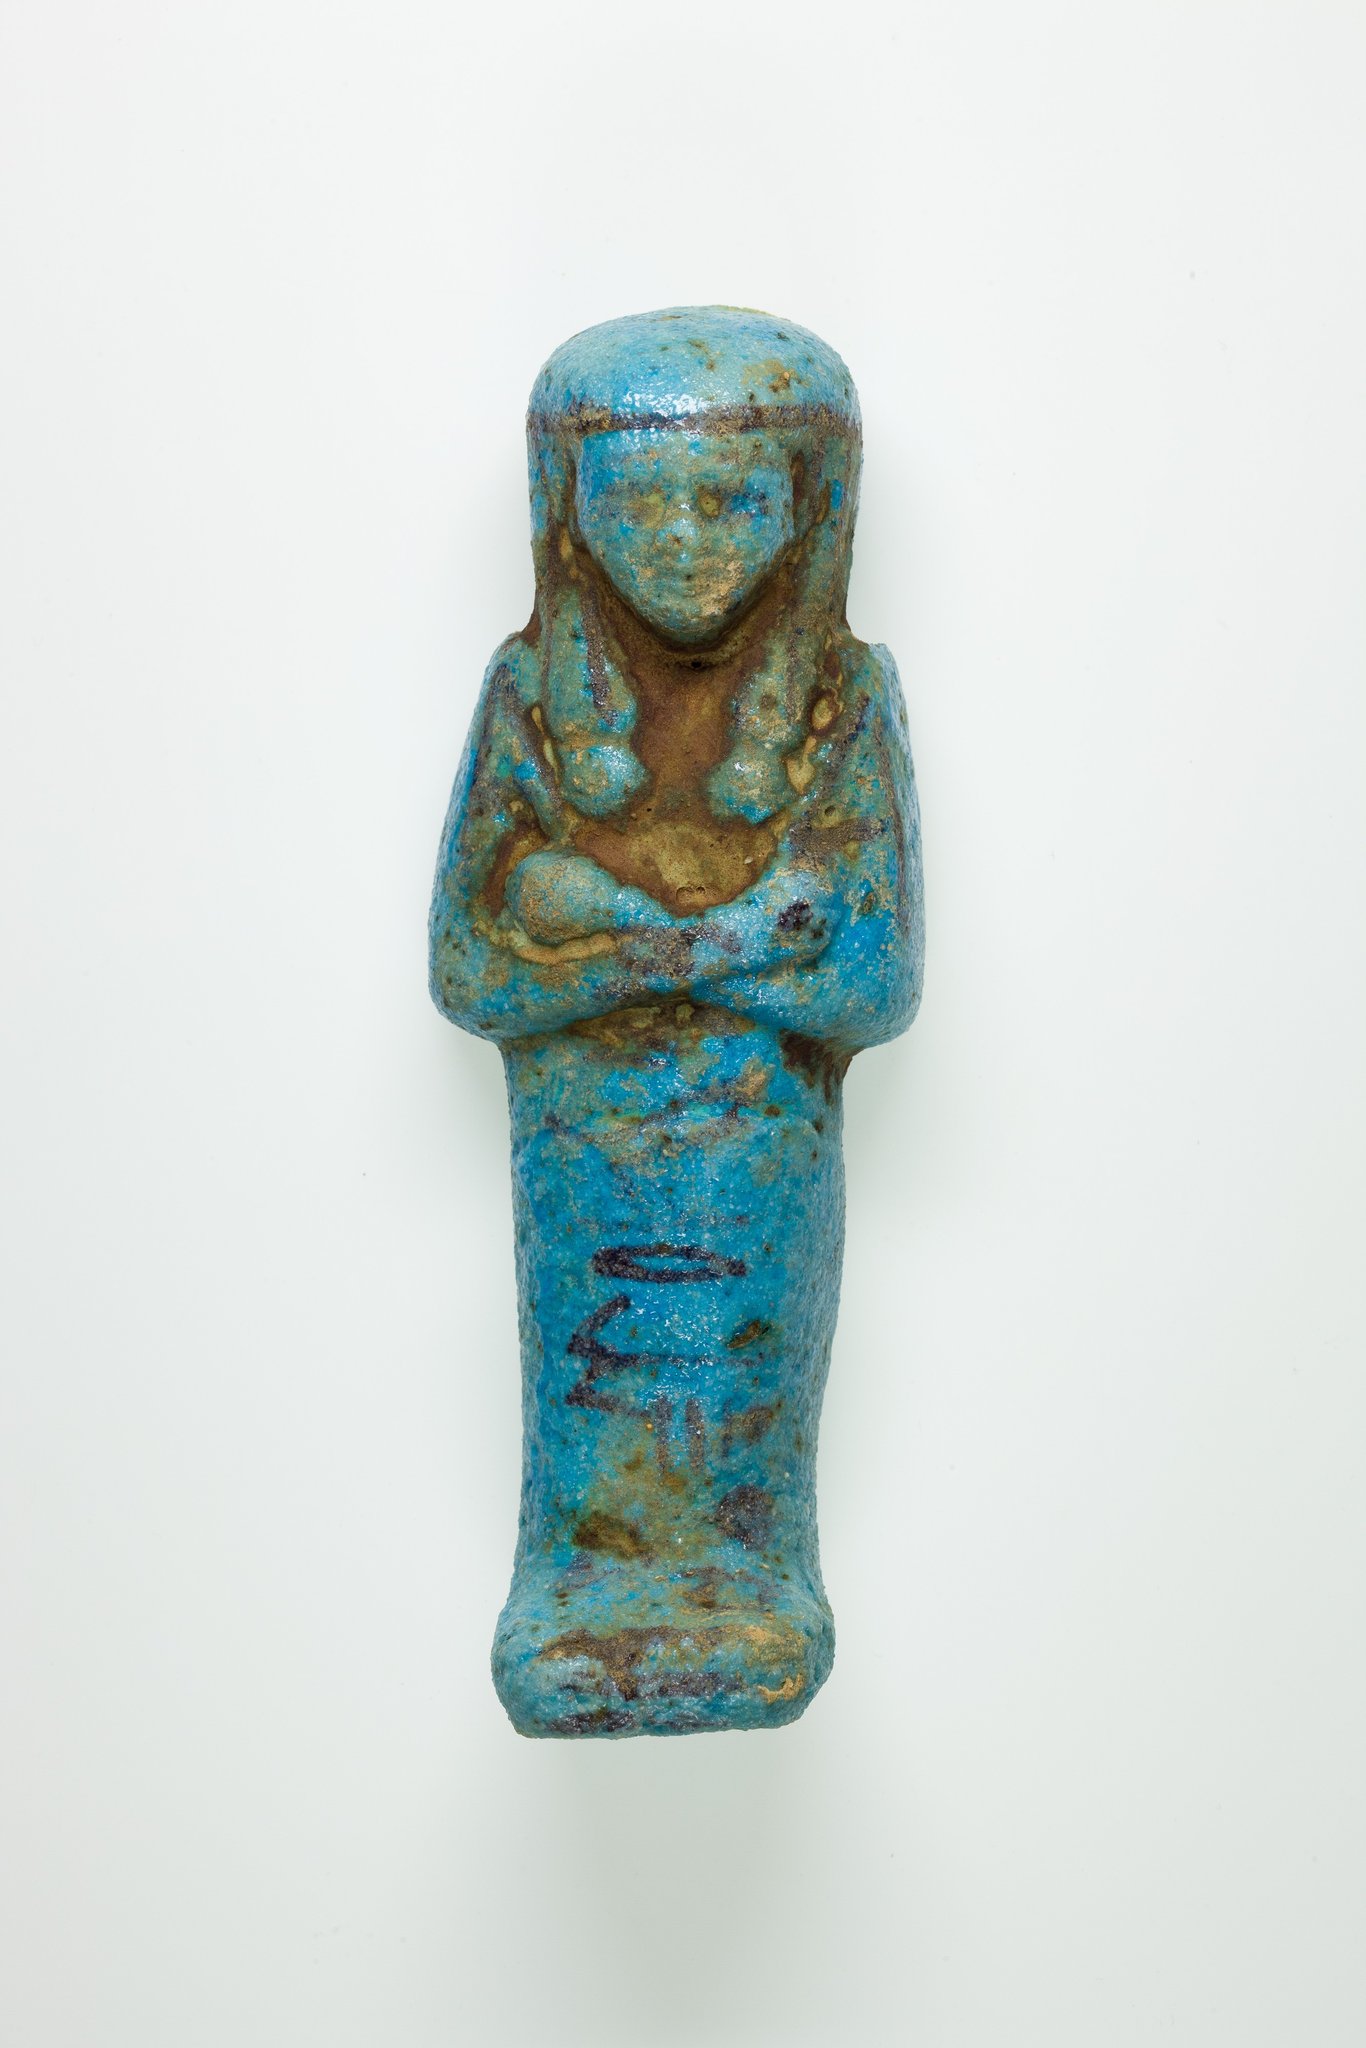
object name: worker shabti, henettawy c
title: Worker Shabti of Henettawy (C), Daughter of Isetemkheb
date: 990-970 BCE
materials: faience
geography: egypt